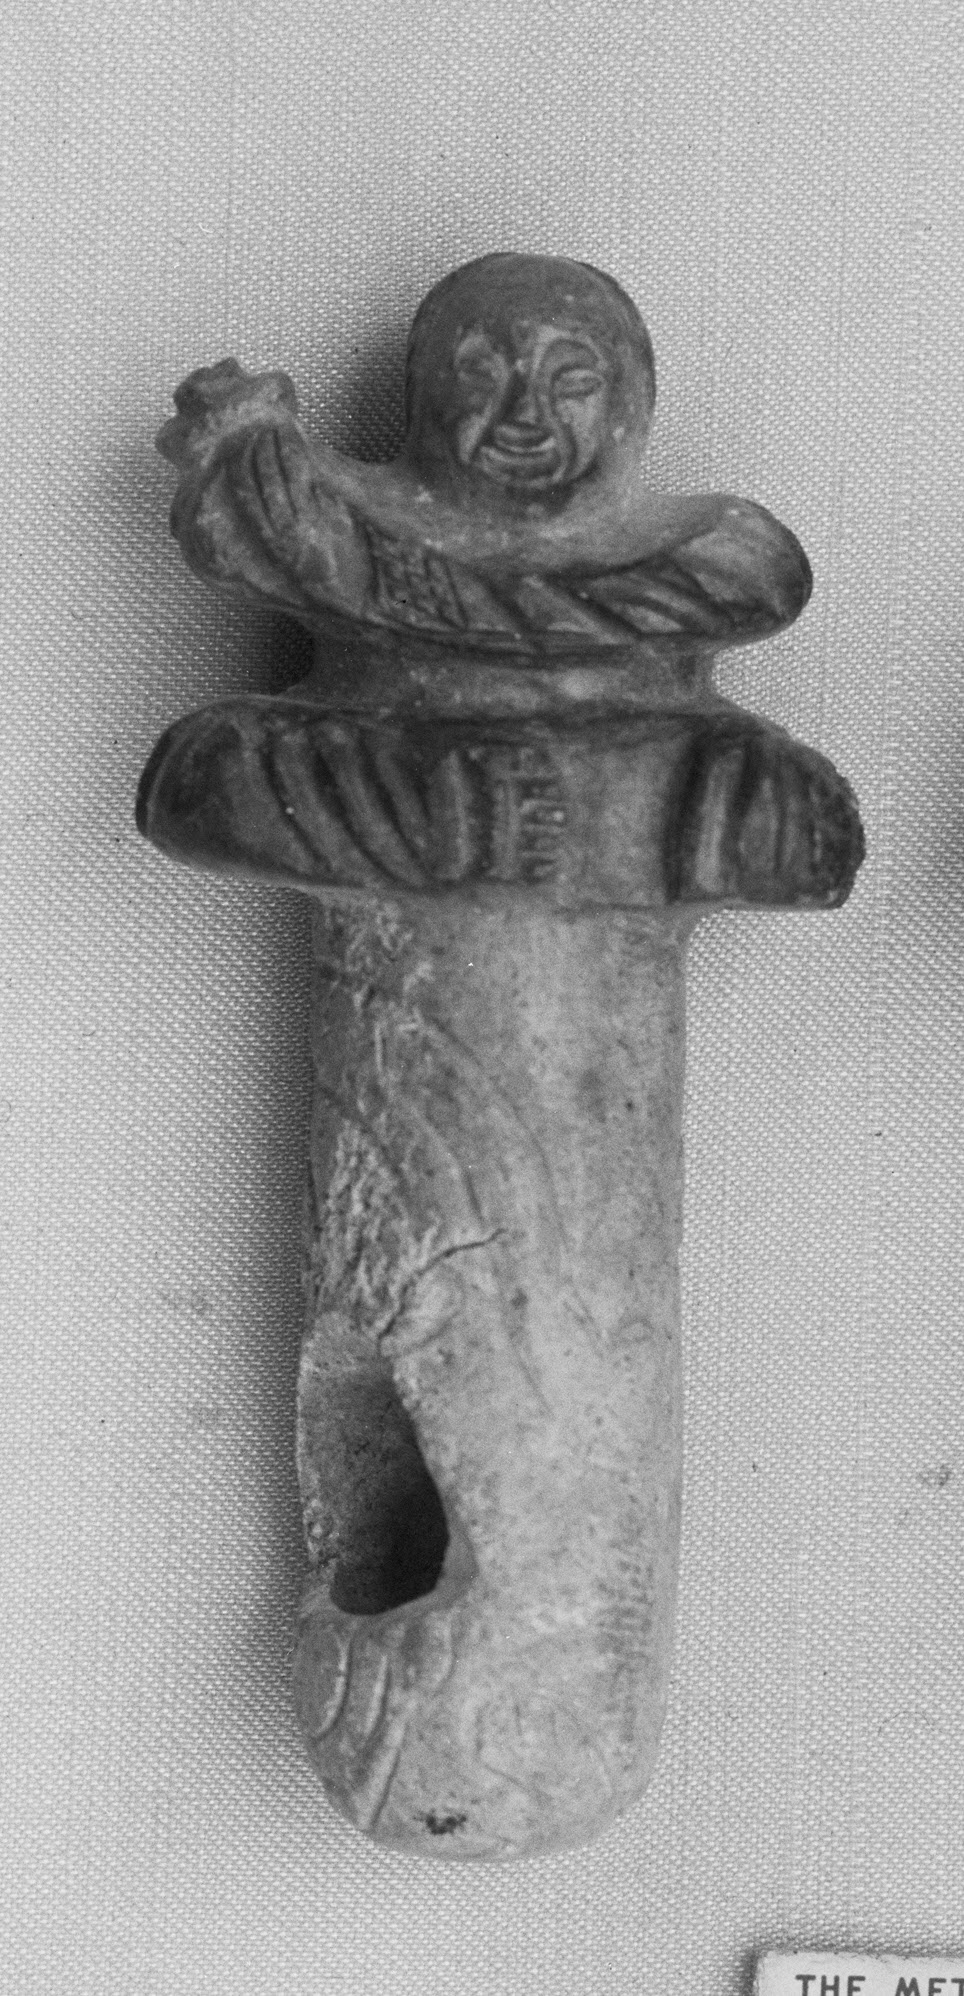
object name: finial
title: Finial with child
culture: chinese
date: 1368-1644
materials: jade